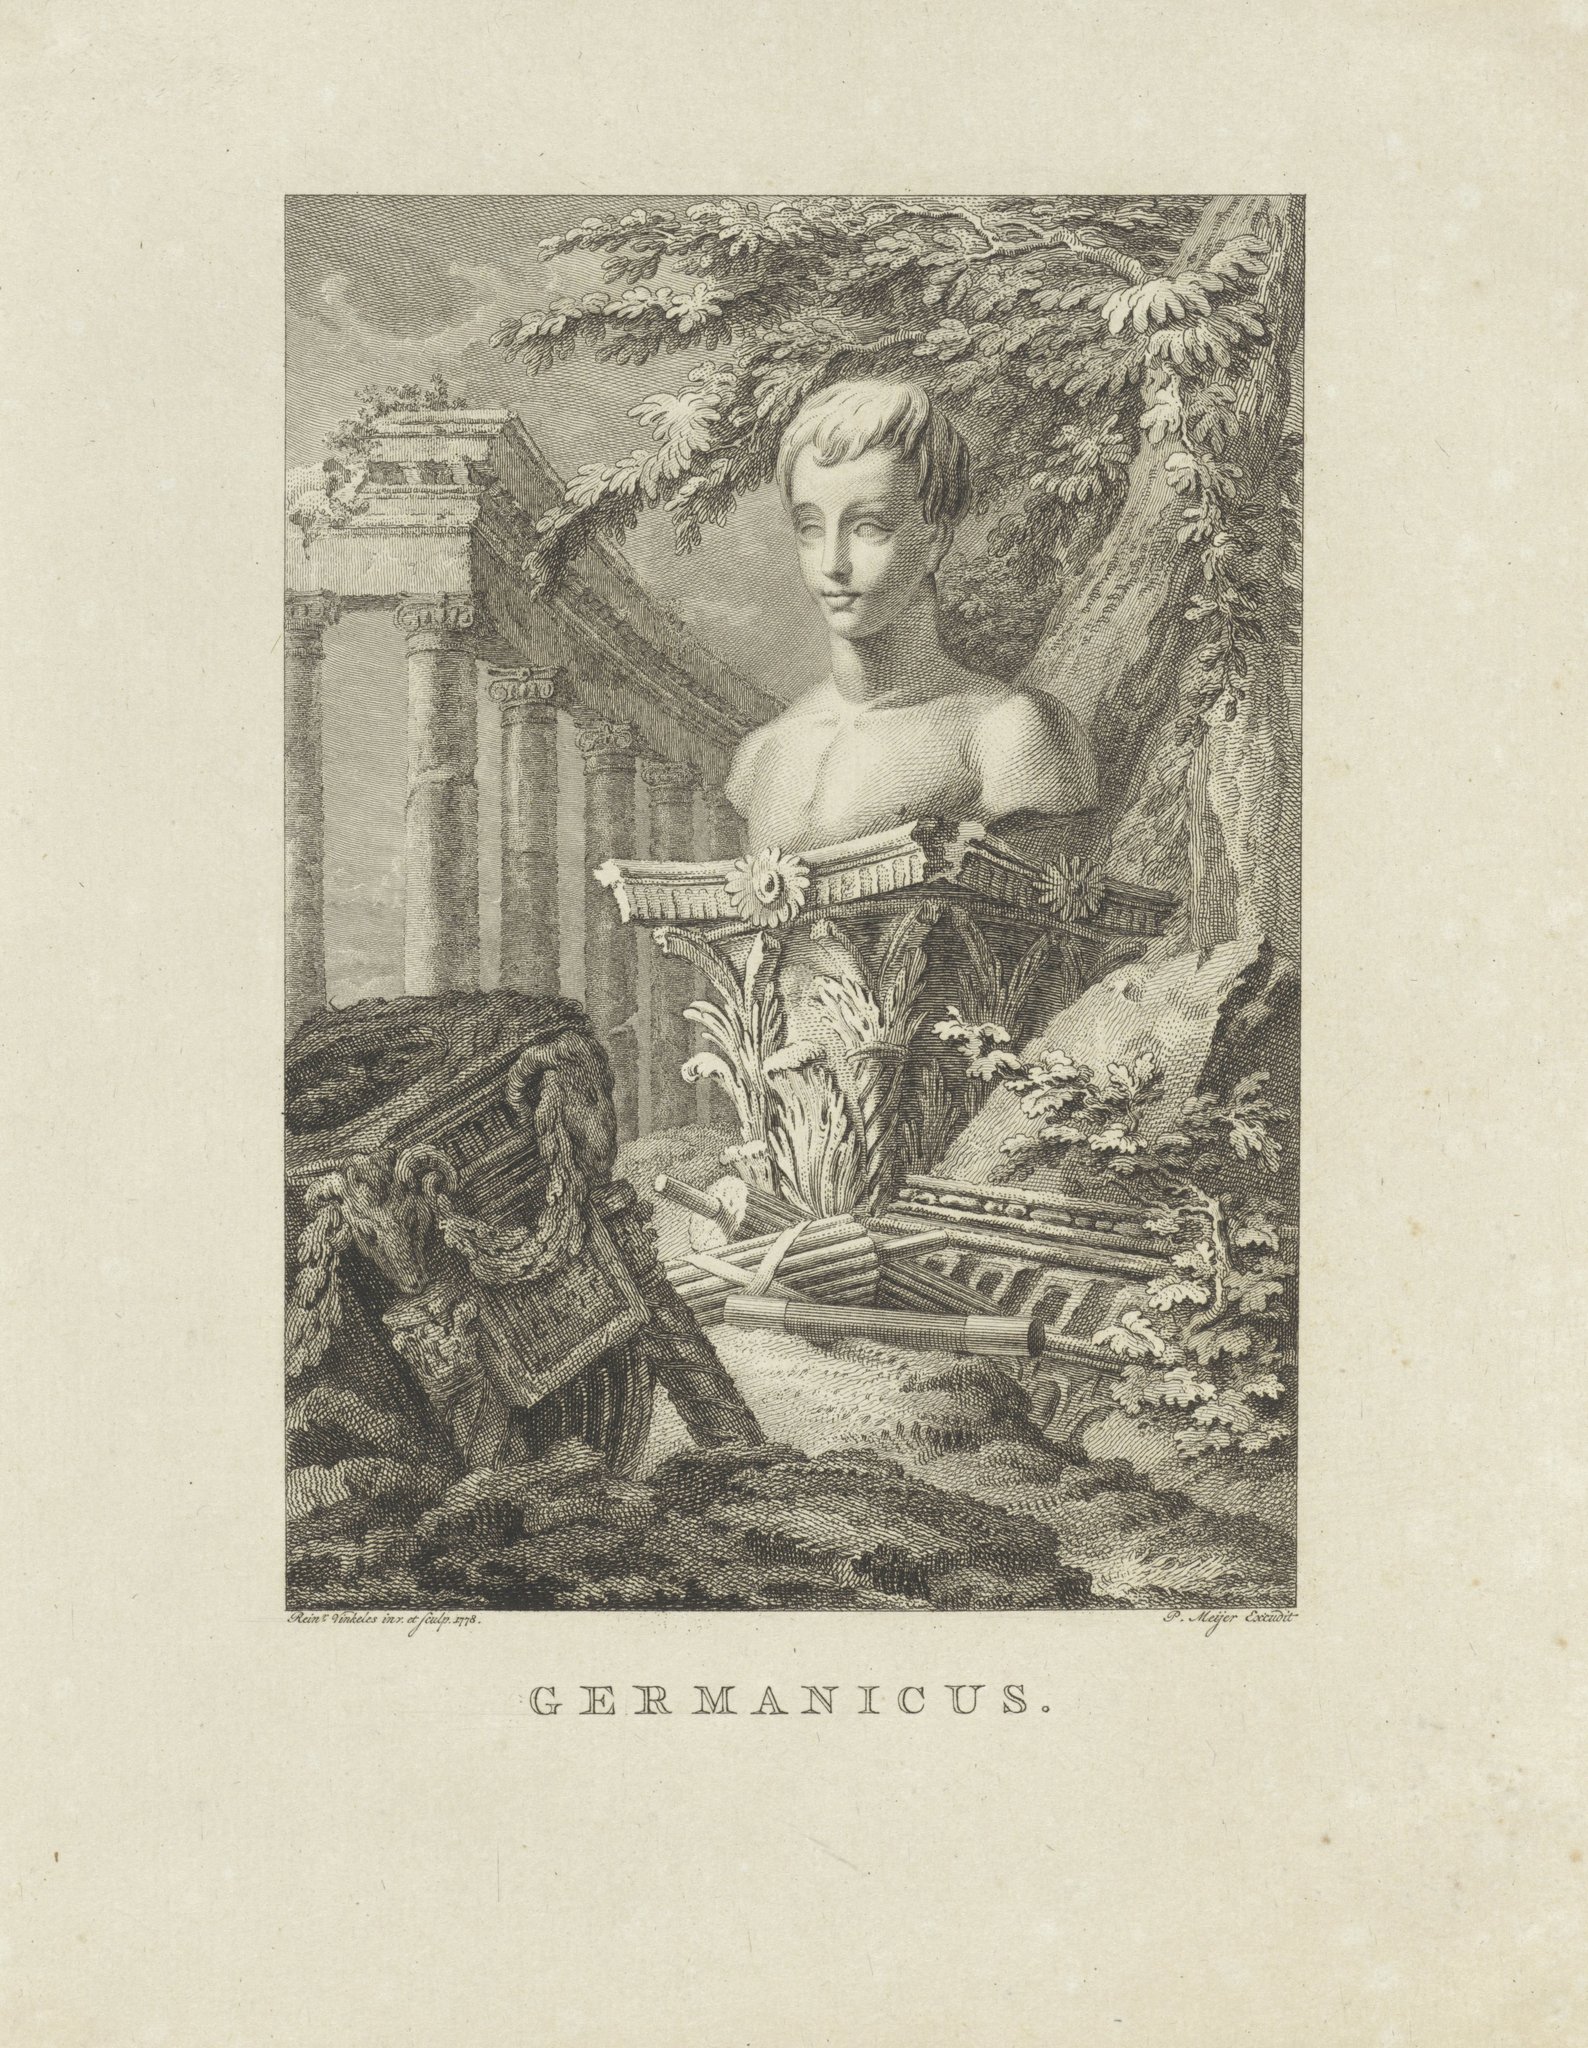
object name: print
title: Buste van Germanicus in een landschap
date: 1778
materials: paper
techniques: engraving, etching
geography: amsterdam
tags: symbols and allegories of law; 'legge', 'legge civile' (ripa) (+ 'fasces cum securibus'), colonnade, ruin of a building ~ architecture, capital (~ column, pillar), baton of general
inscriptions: collector's mark: Lugt 240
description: Buste van de Romeinse veldheer Germanicus, op een sokkel in een landschap met een klassieke ruïne met een zuilenrij. Op de grond liggen twee fasces en een commanostaf.